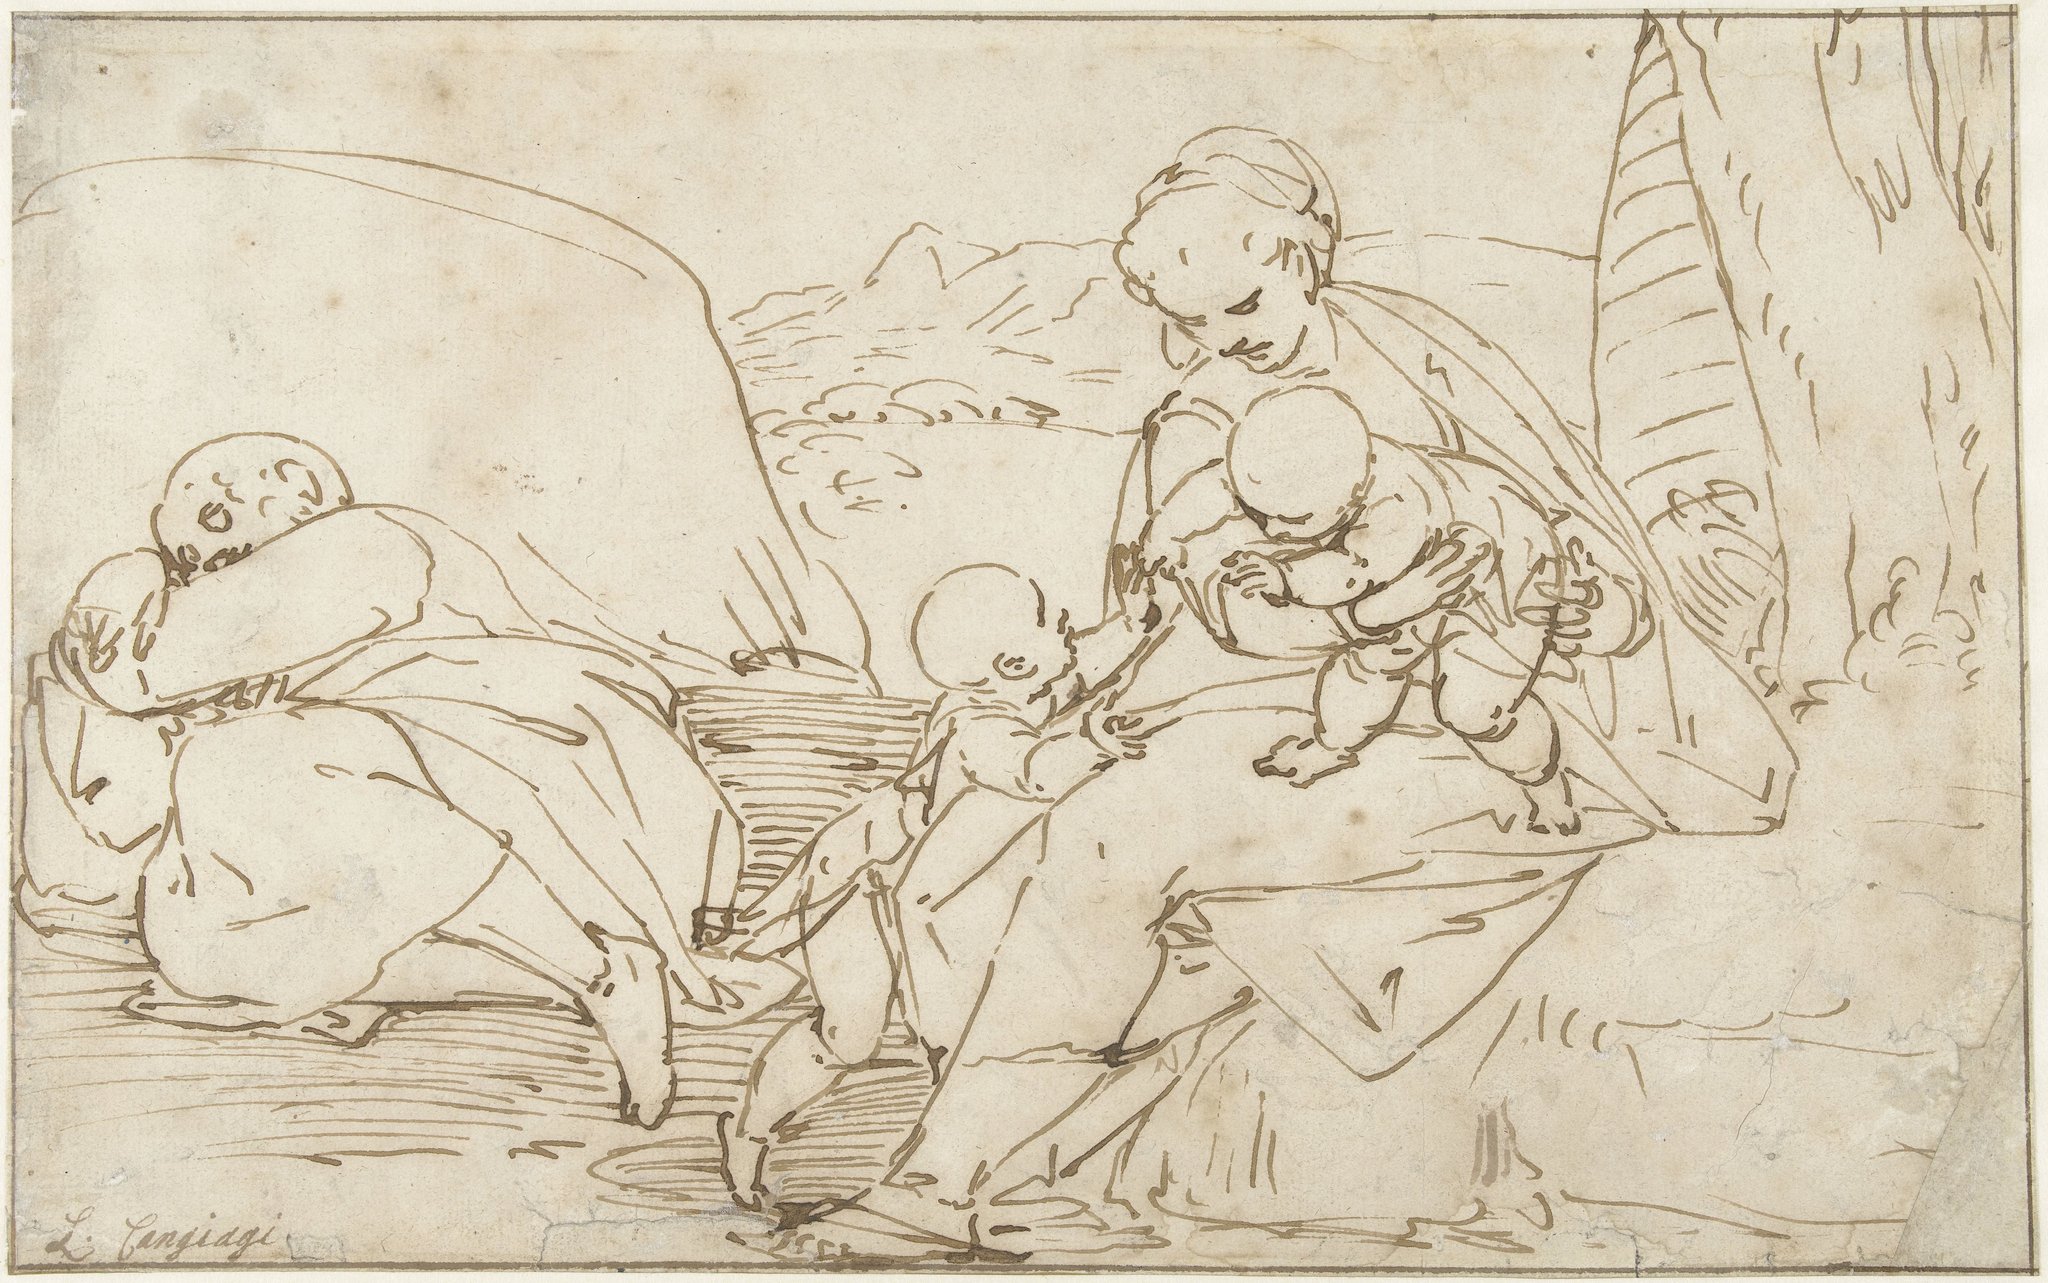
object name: drawing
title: Heilige Familie met Johannes de Doper als kind in een landschap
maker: luca cambiaso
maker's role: draughtsman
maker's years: 1527-1585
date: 1537-1585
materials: ink, paper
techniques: pen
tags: holy family with john the baptist (as child)